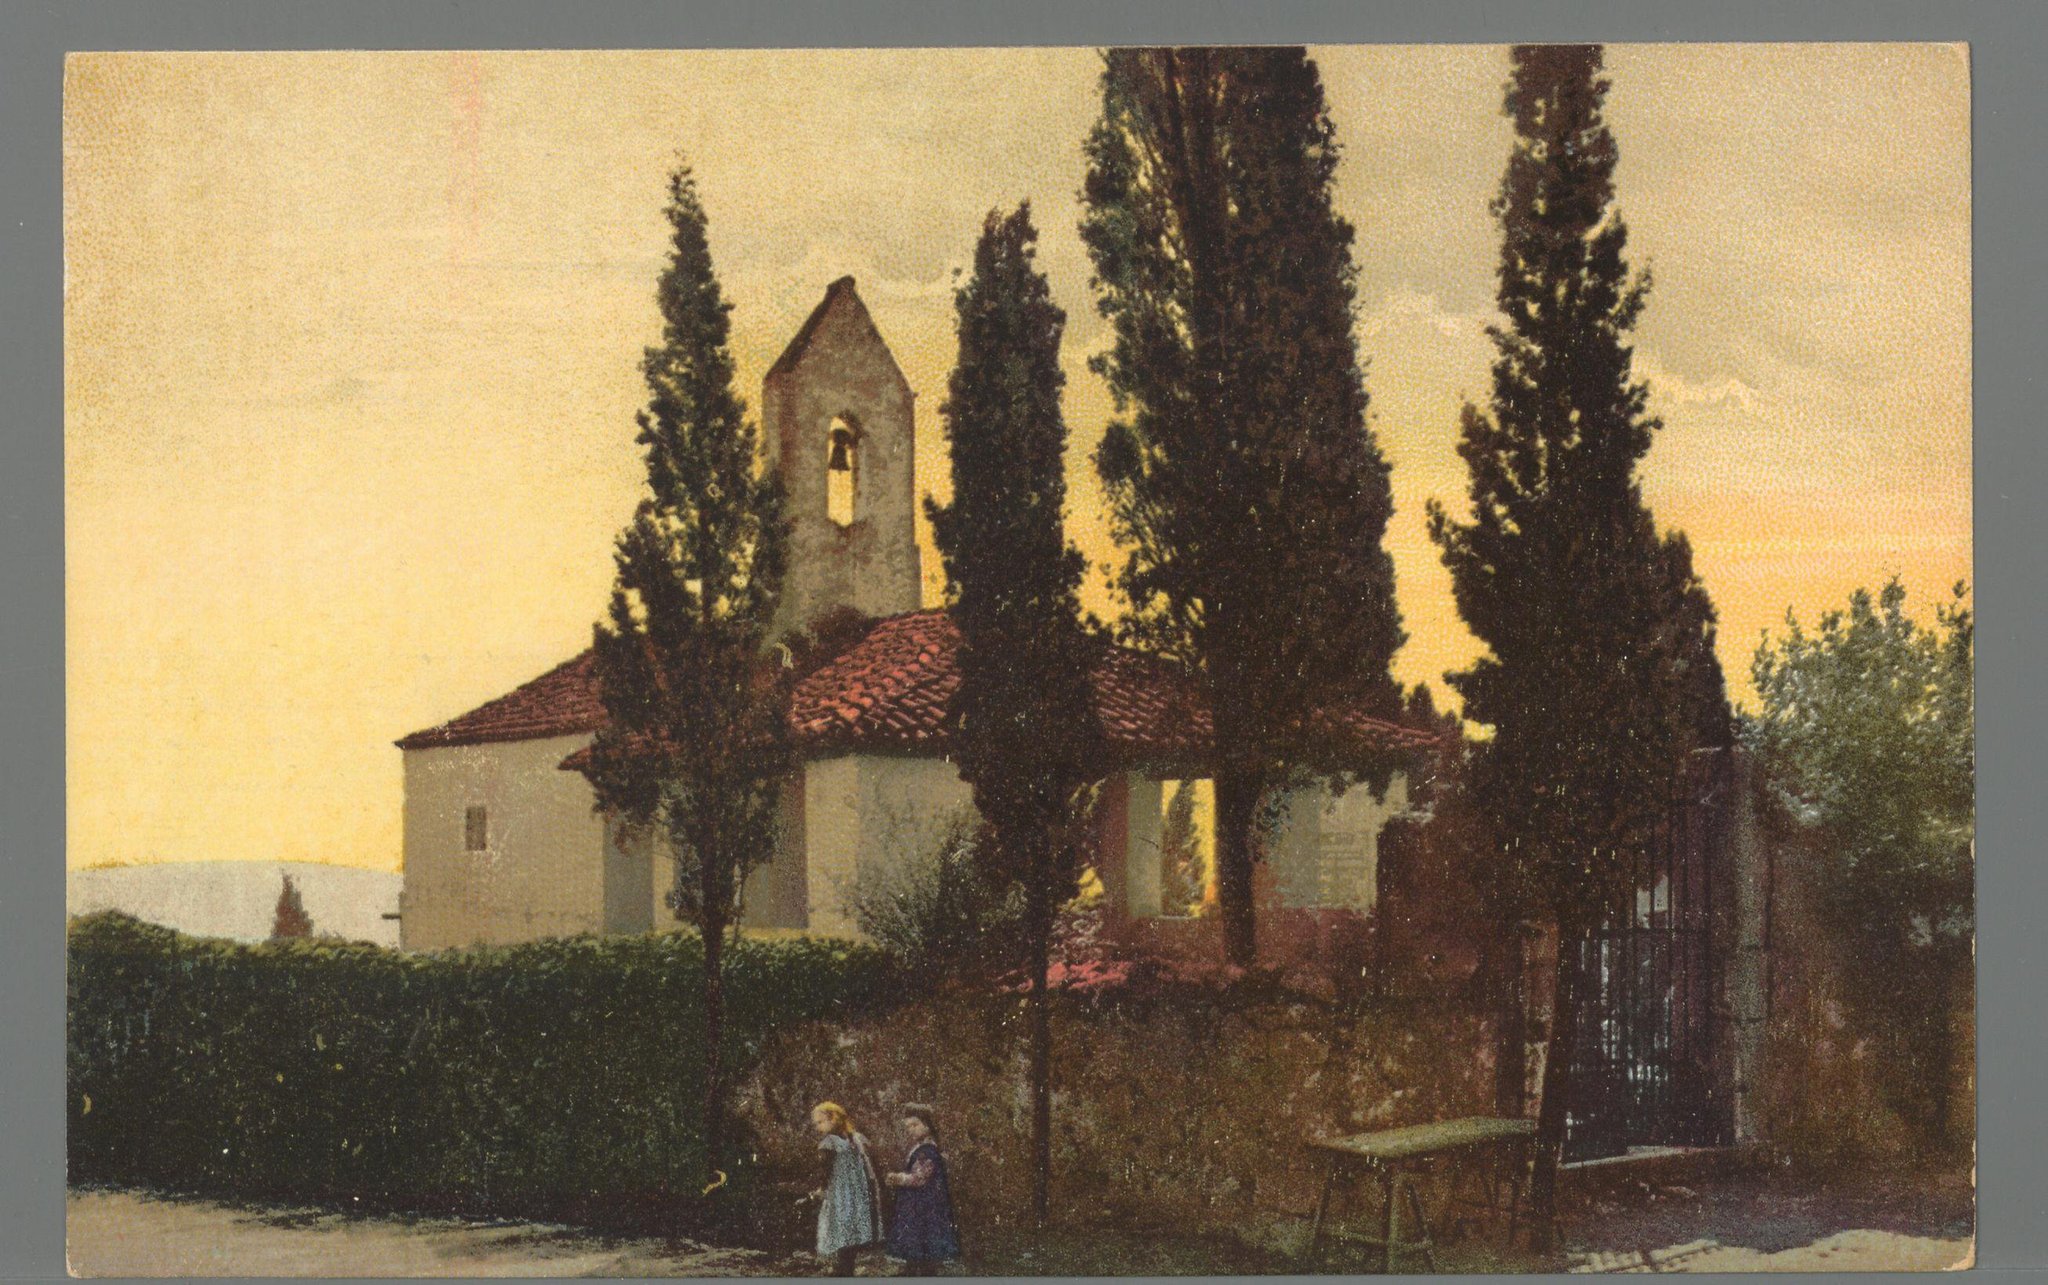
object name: photomechanical print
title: Gezicht op een kerk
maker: Anonymous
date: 1905-1933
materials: cardboard, photographic process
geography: germany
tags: church (exterior), germany